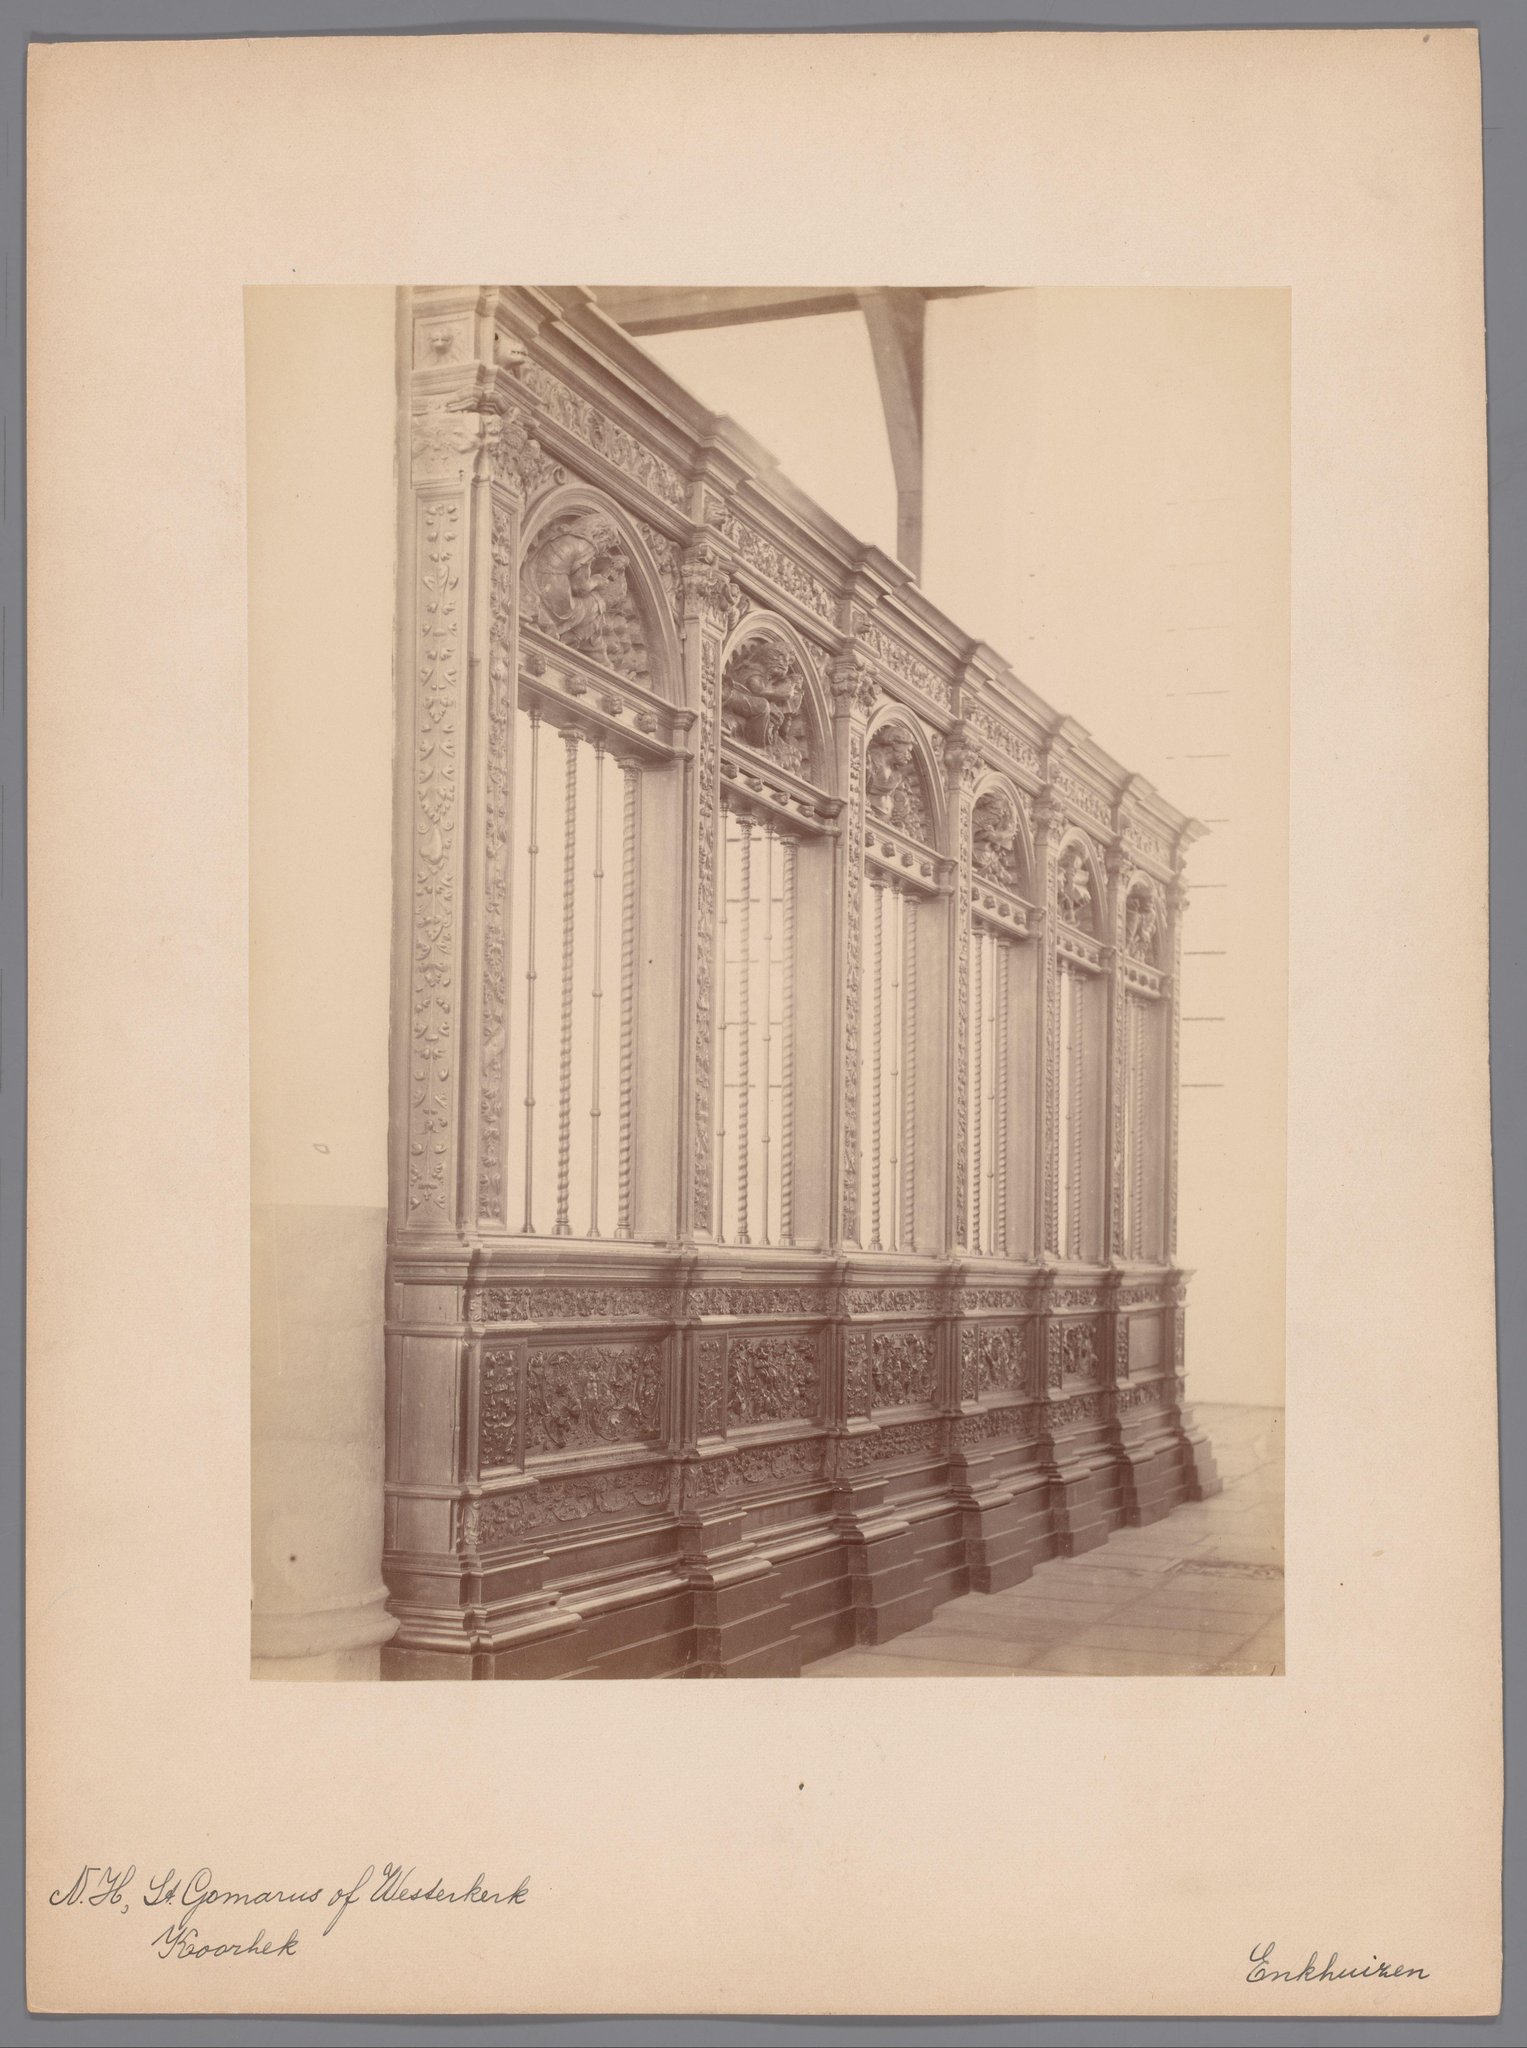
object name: photograph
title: Detail van koorhek in de Westerkerk te Enkhuizen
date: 1880-1895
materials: cardboard, photographic support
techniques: albumen print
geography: westerkerk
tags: interior of church, choir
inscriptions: annotation: ‘Koorhek in de Westekerk te Enkhuizen’, annotation: ‘N.H, St. Gomarus of Westerkerk/ Koorhek/ Enkhuizen’